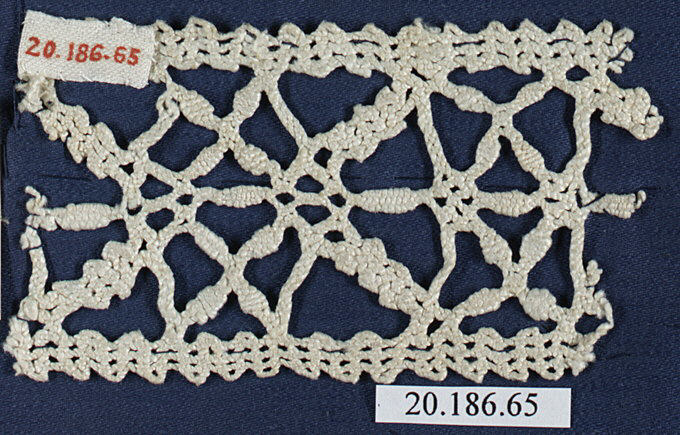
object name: insertion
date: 1501-1600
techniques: lace